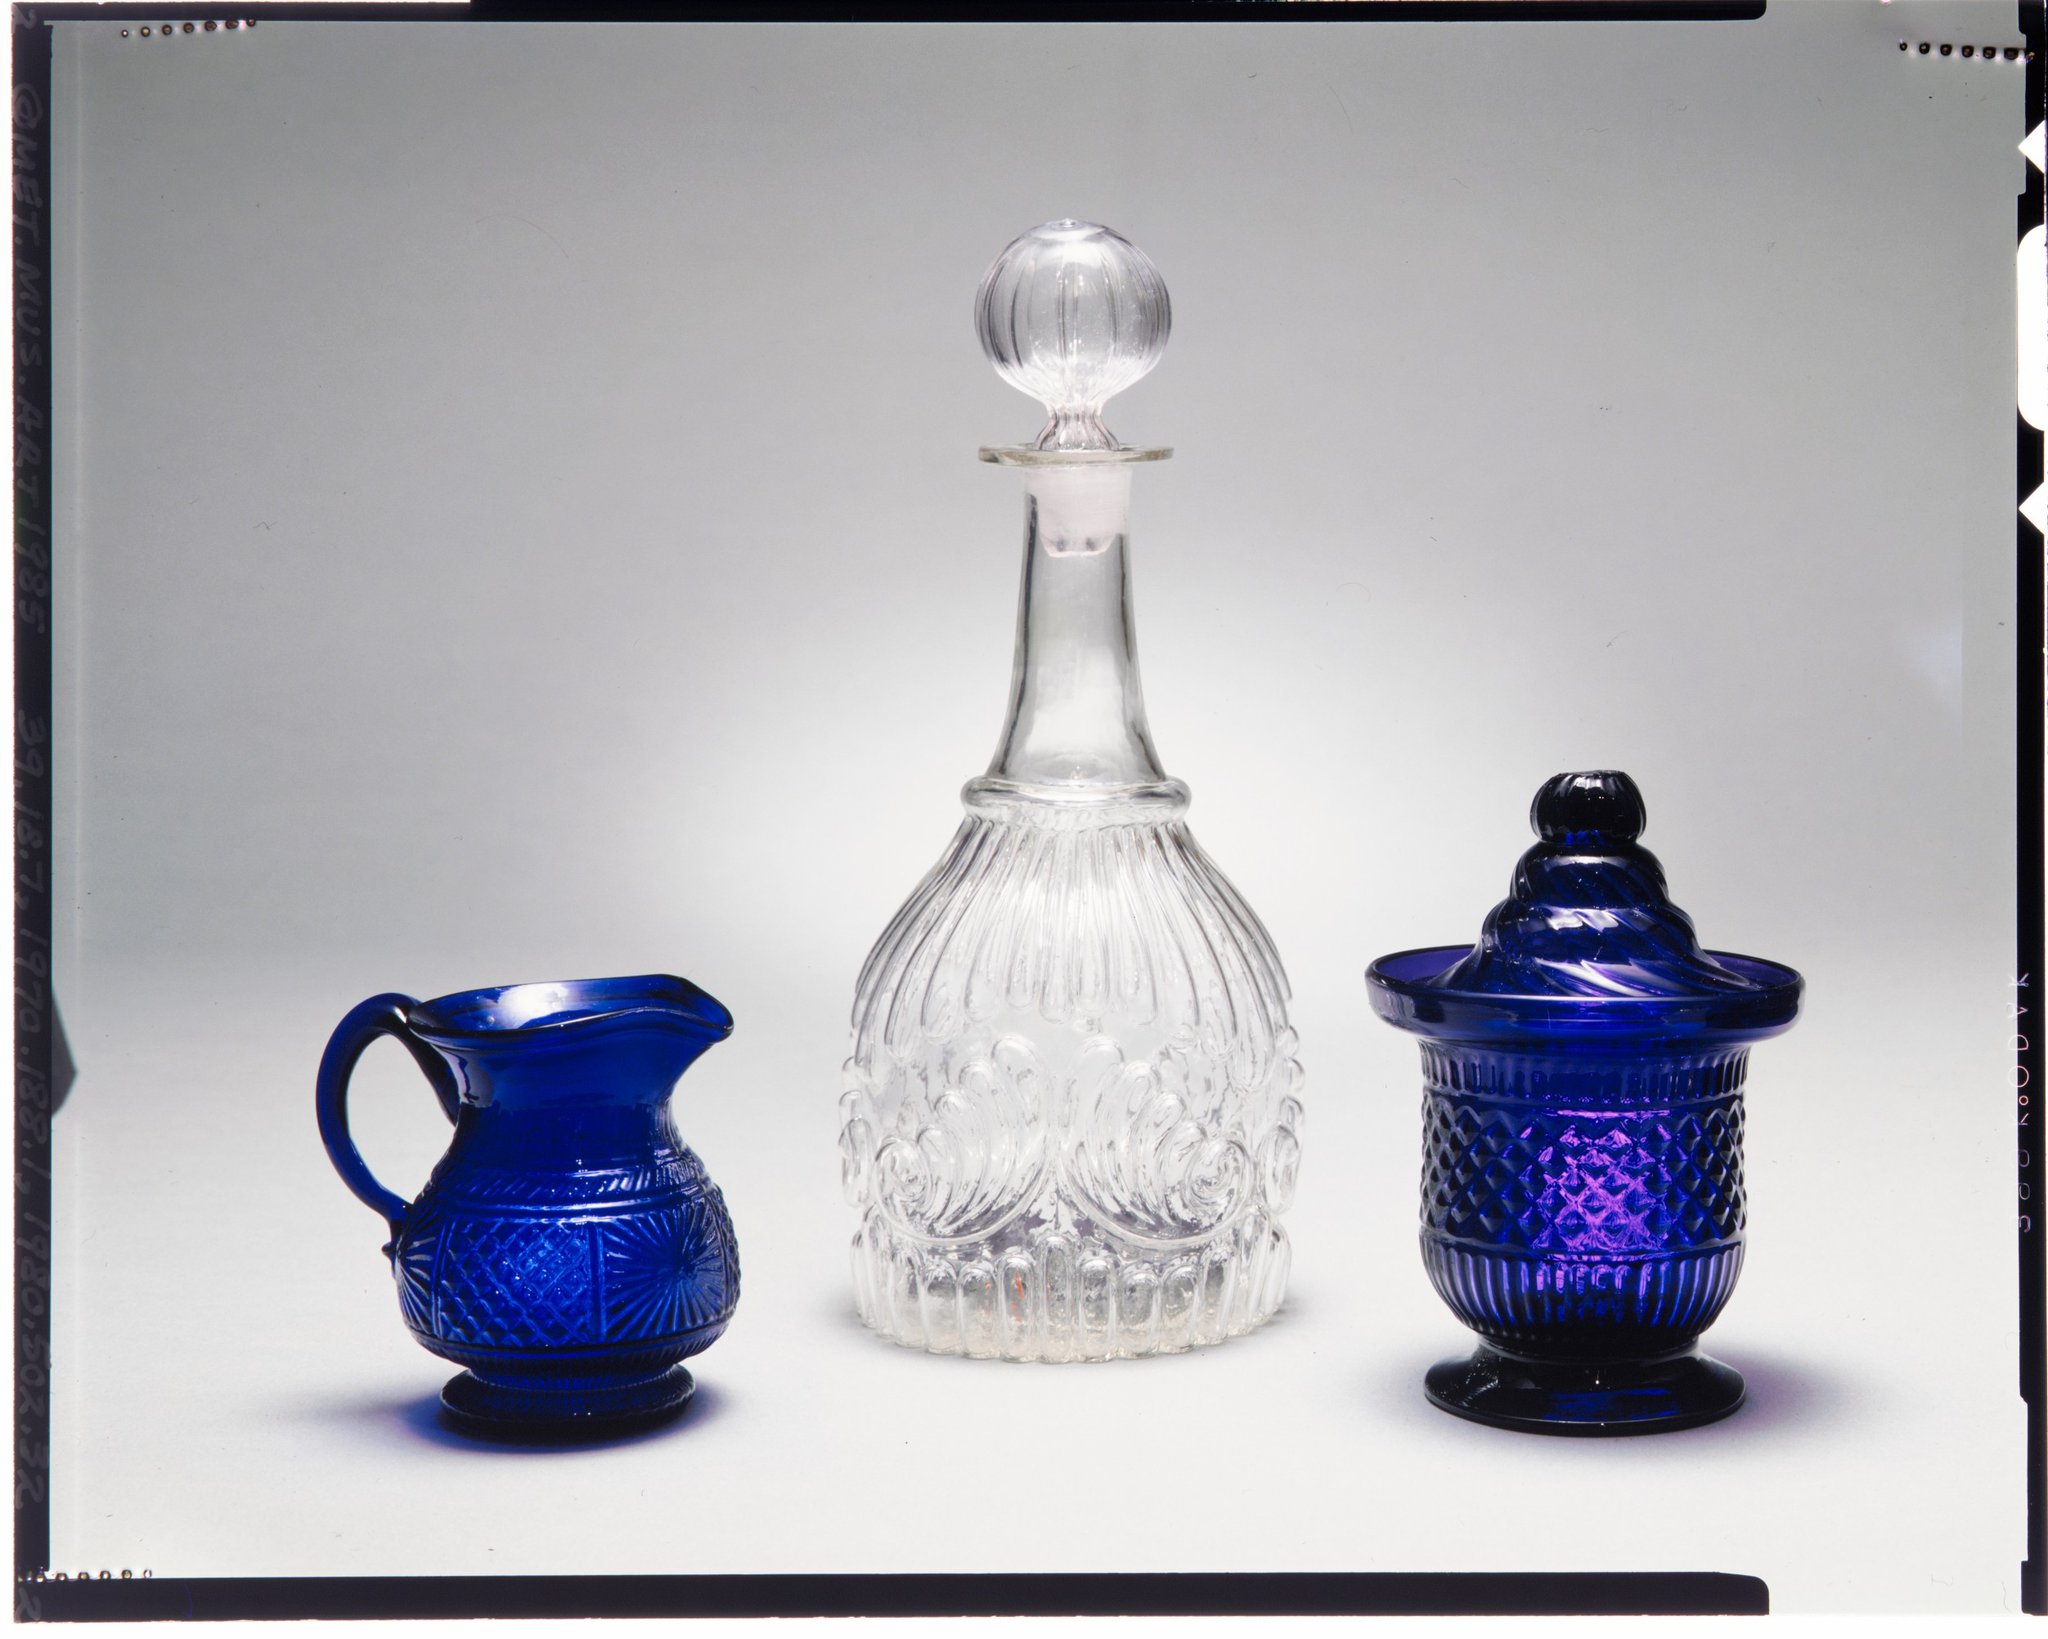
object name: cream pot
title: Creamer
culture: american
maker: boston & sandwich glass company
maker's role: maker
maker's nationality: american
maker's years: 1825-1888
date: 1825-1840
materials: glass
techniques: glassblowing, molding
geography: united states